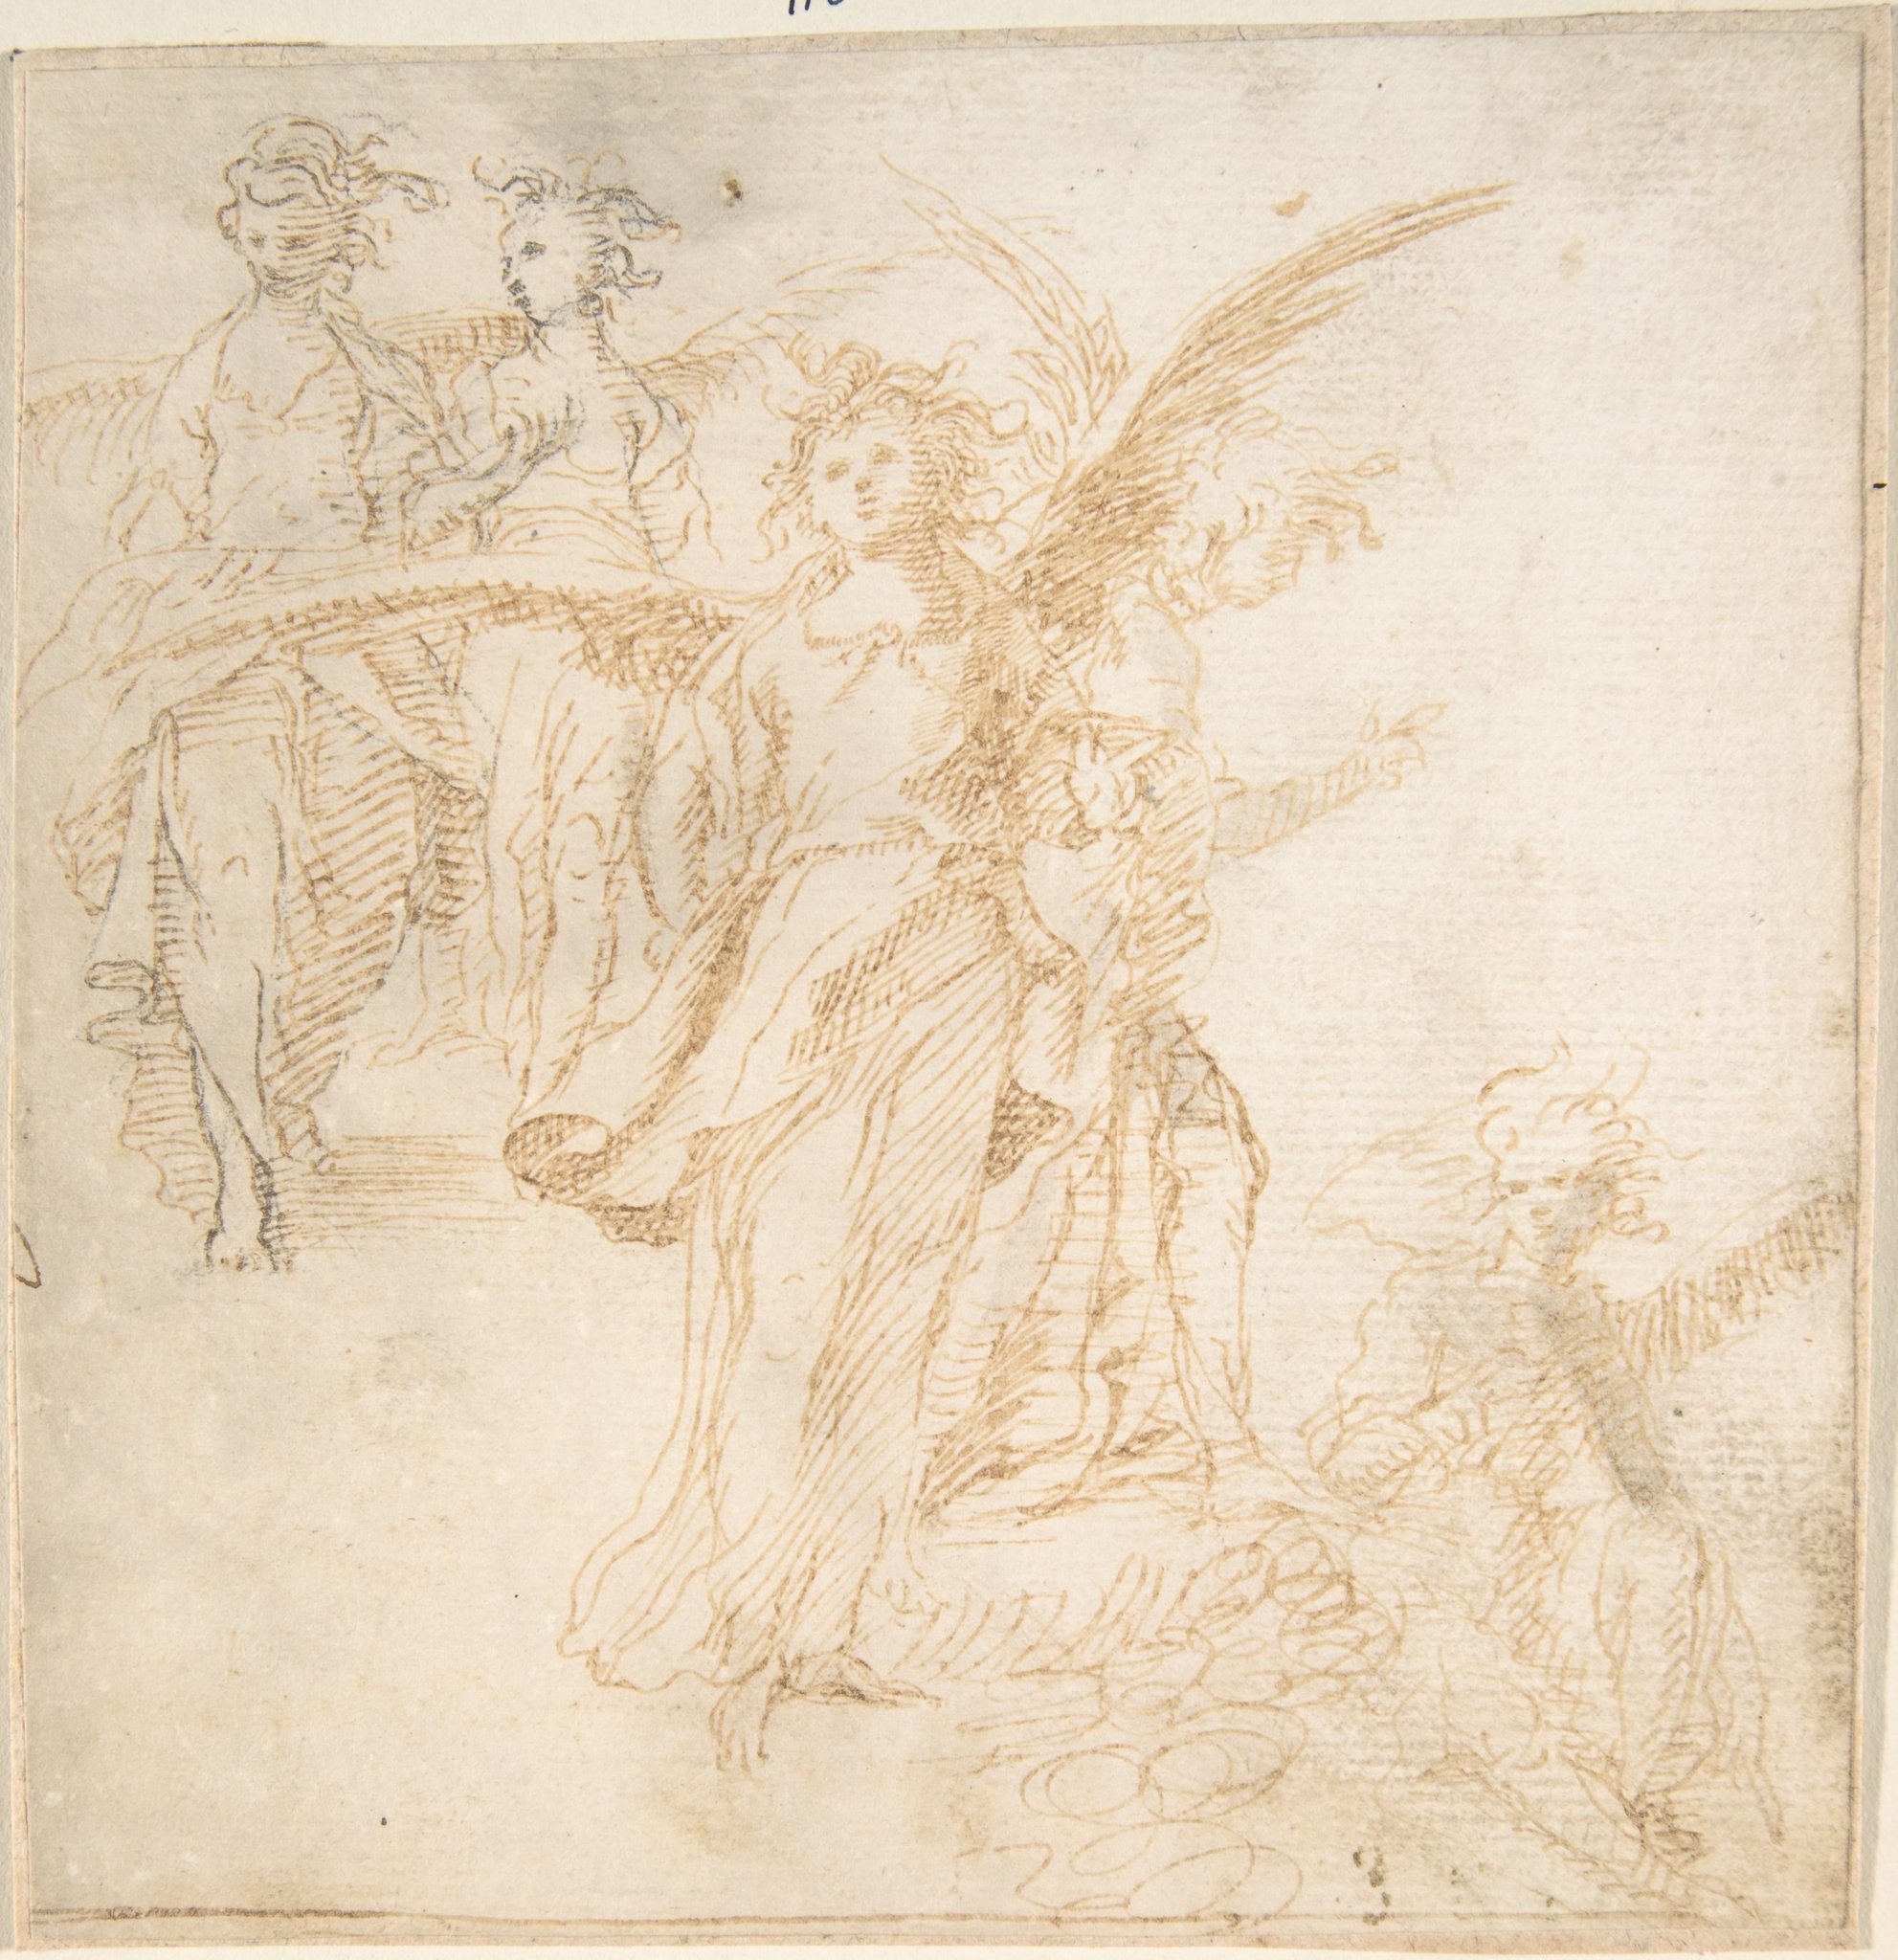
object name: drawing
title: Studies for Figures of Five Angels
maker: anonymous, spanish, school of seville, 17th century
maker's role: artist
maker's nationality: spanish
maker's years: 1600-1700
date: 1601-1700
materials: chalk, ink, paper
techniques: brush, pen, drawing, wash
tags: angels